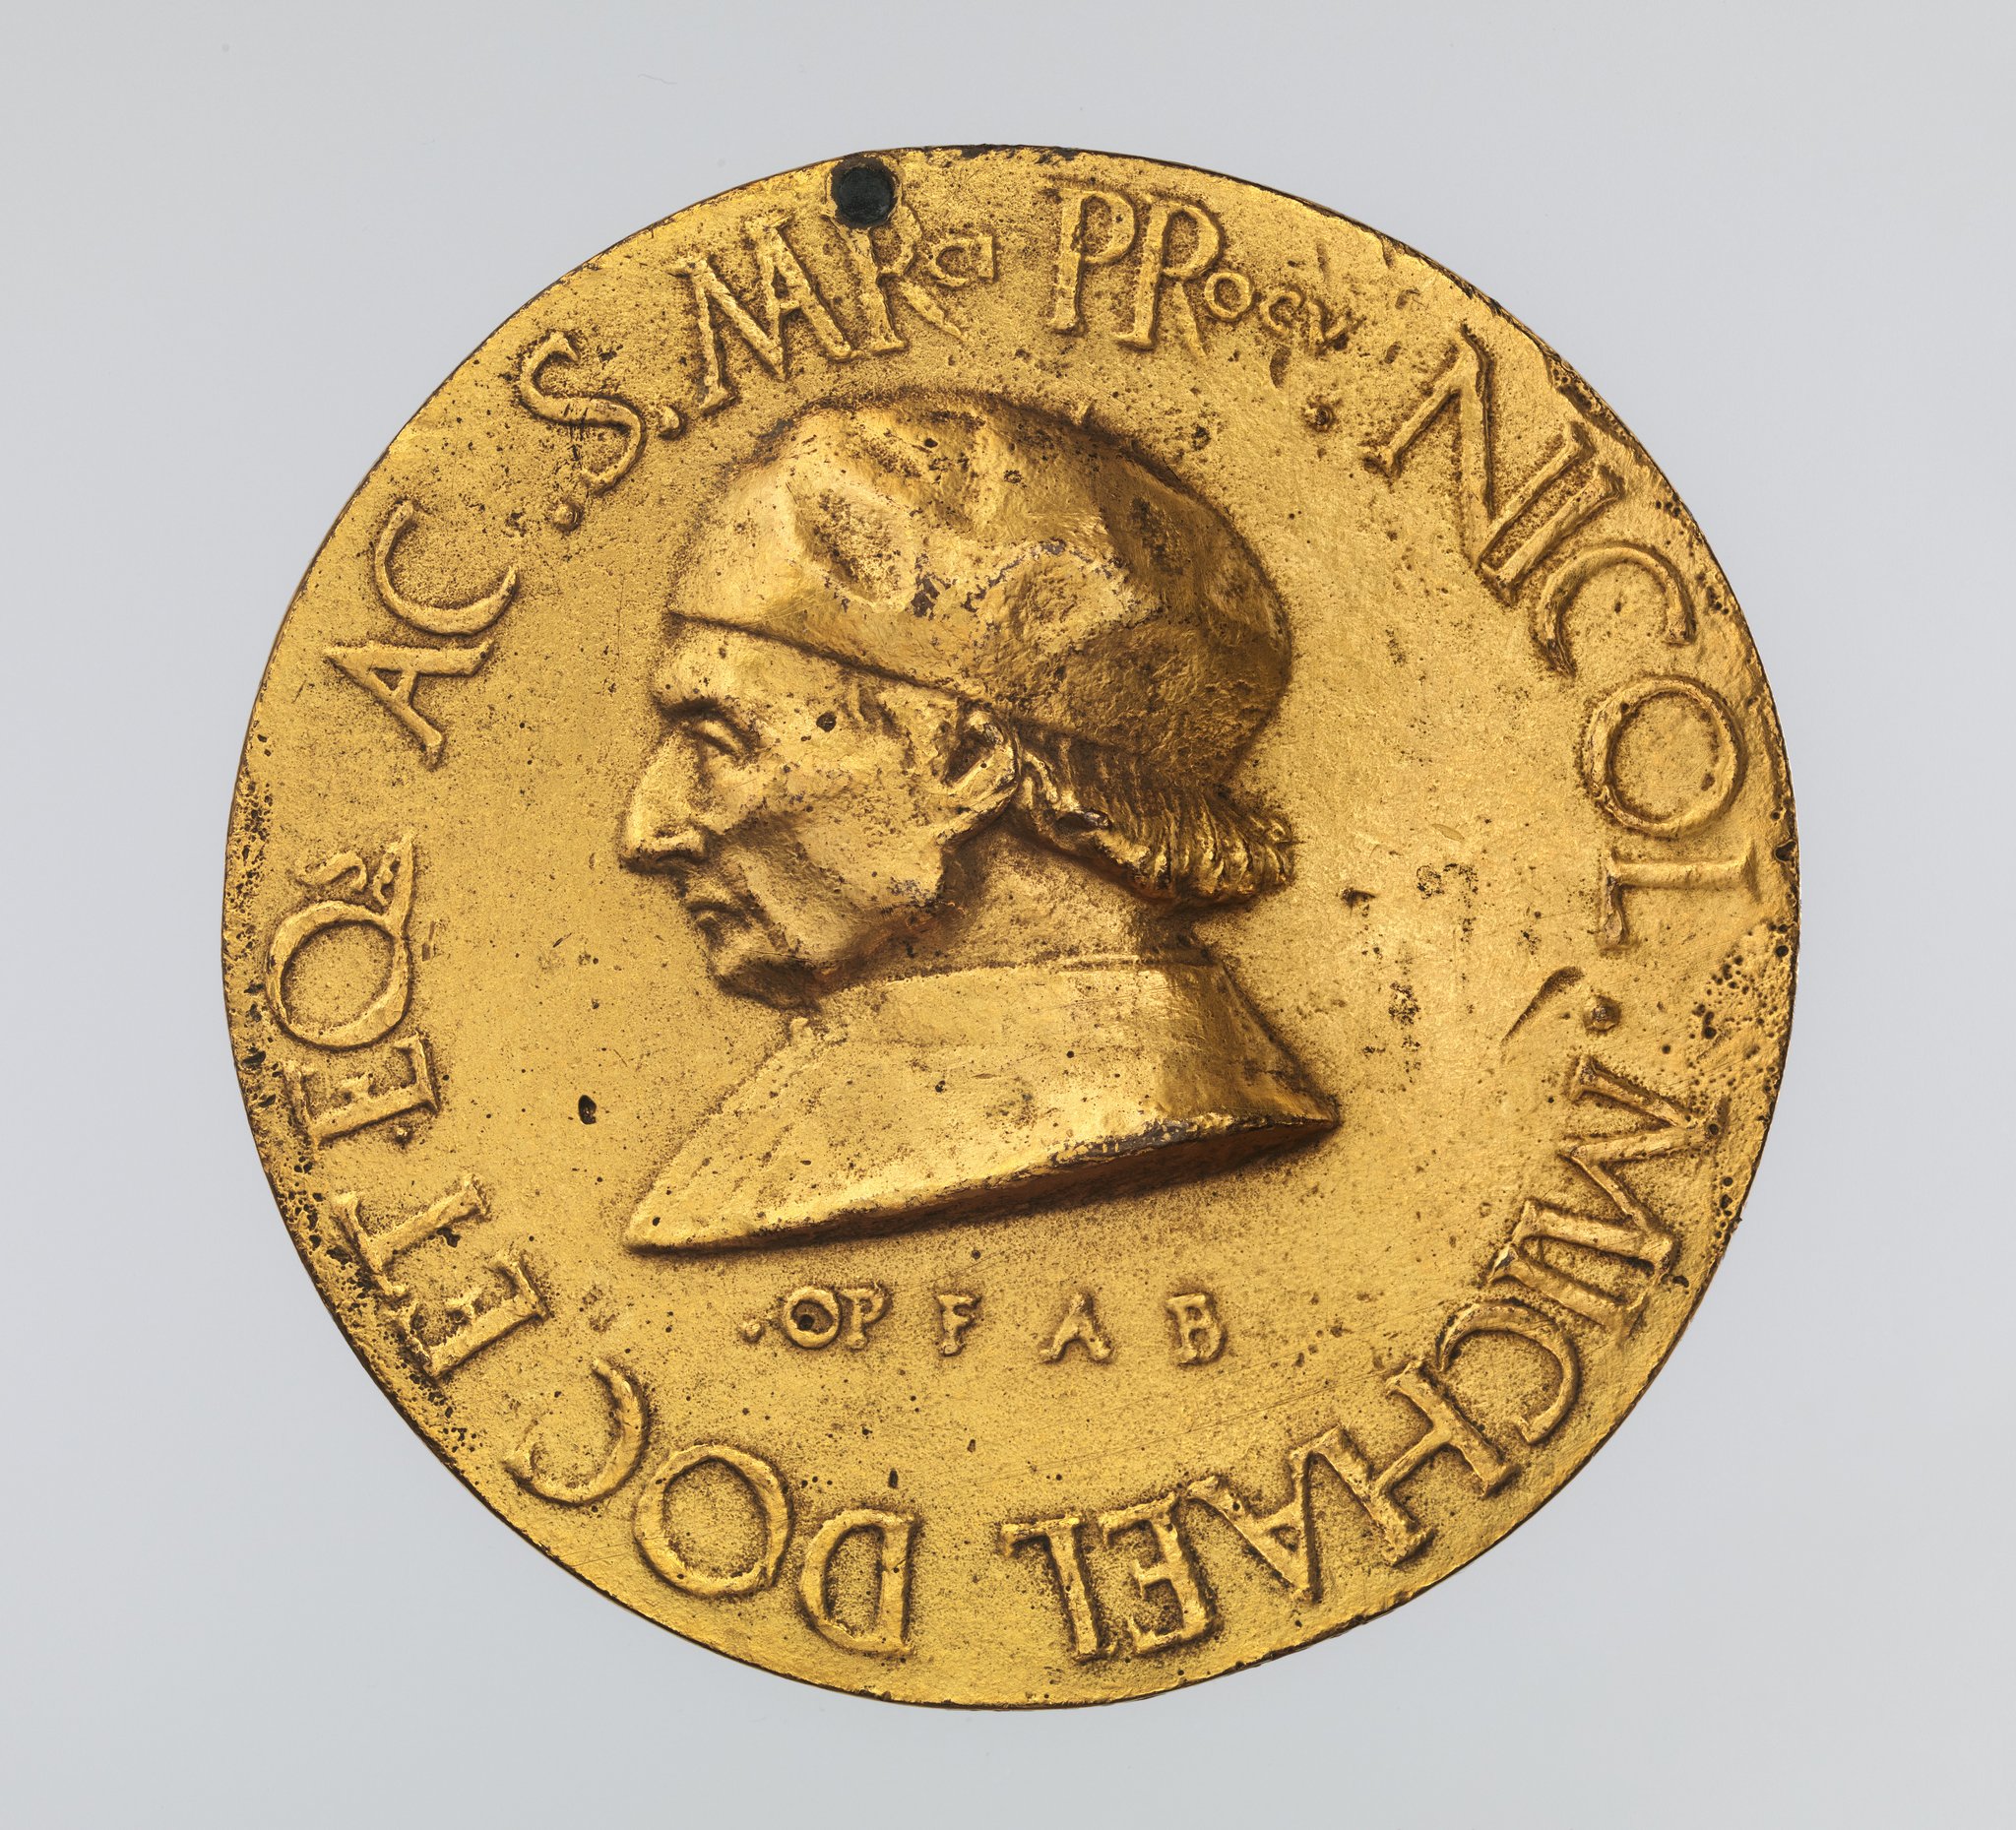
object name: medal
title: Portrait medal of Niccolò Michiel (obverse); Alidea Contarini (reverse)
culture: italian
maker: fra antonio da brescia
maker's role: artist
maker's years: 1480-1525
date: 1500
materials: gilt bronze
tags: men,portraits,profiles